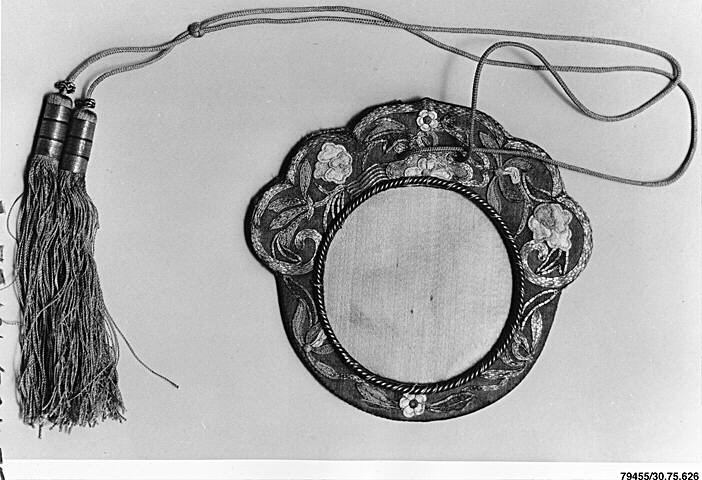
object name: mirror case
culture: chinese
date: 1701-1900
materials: silk